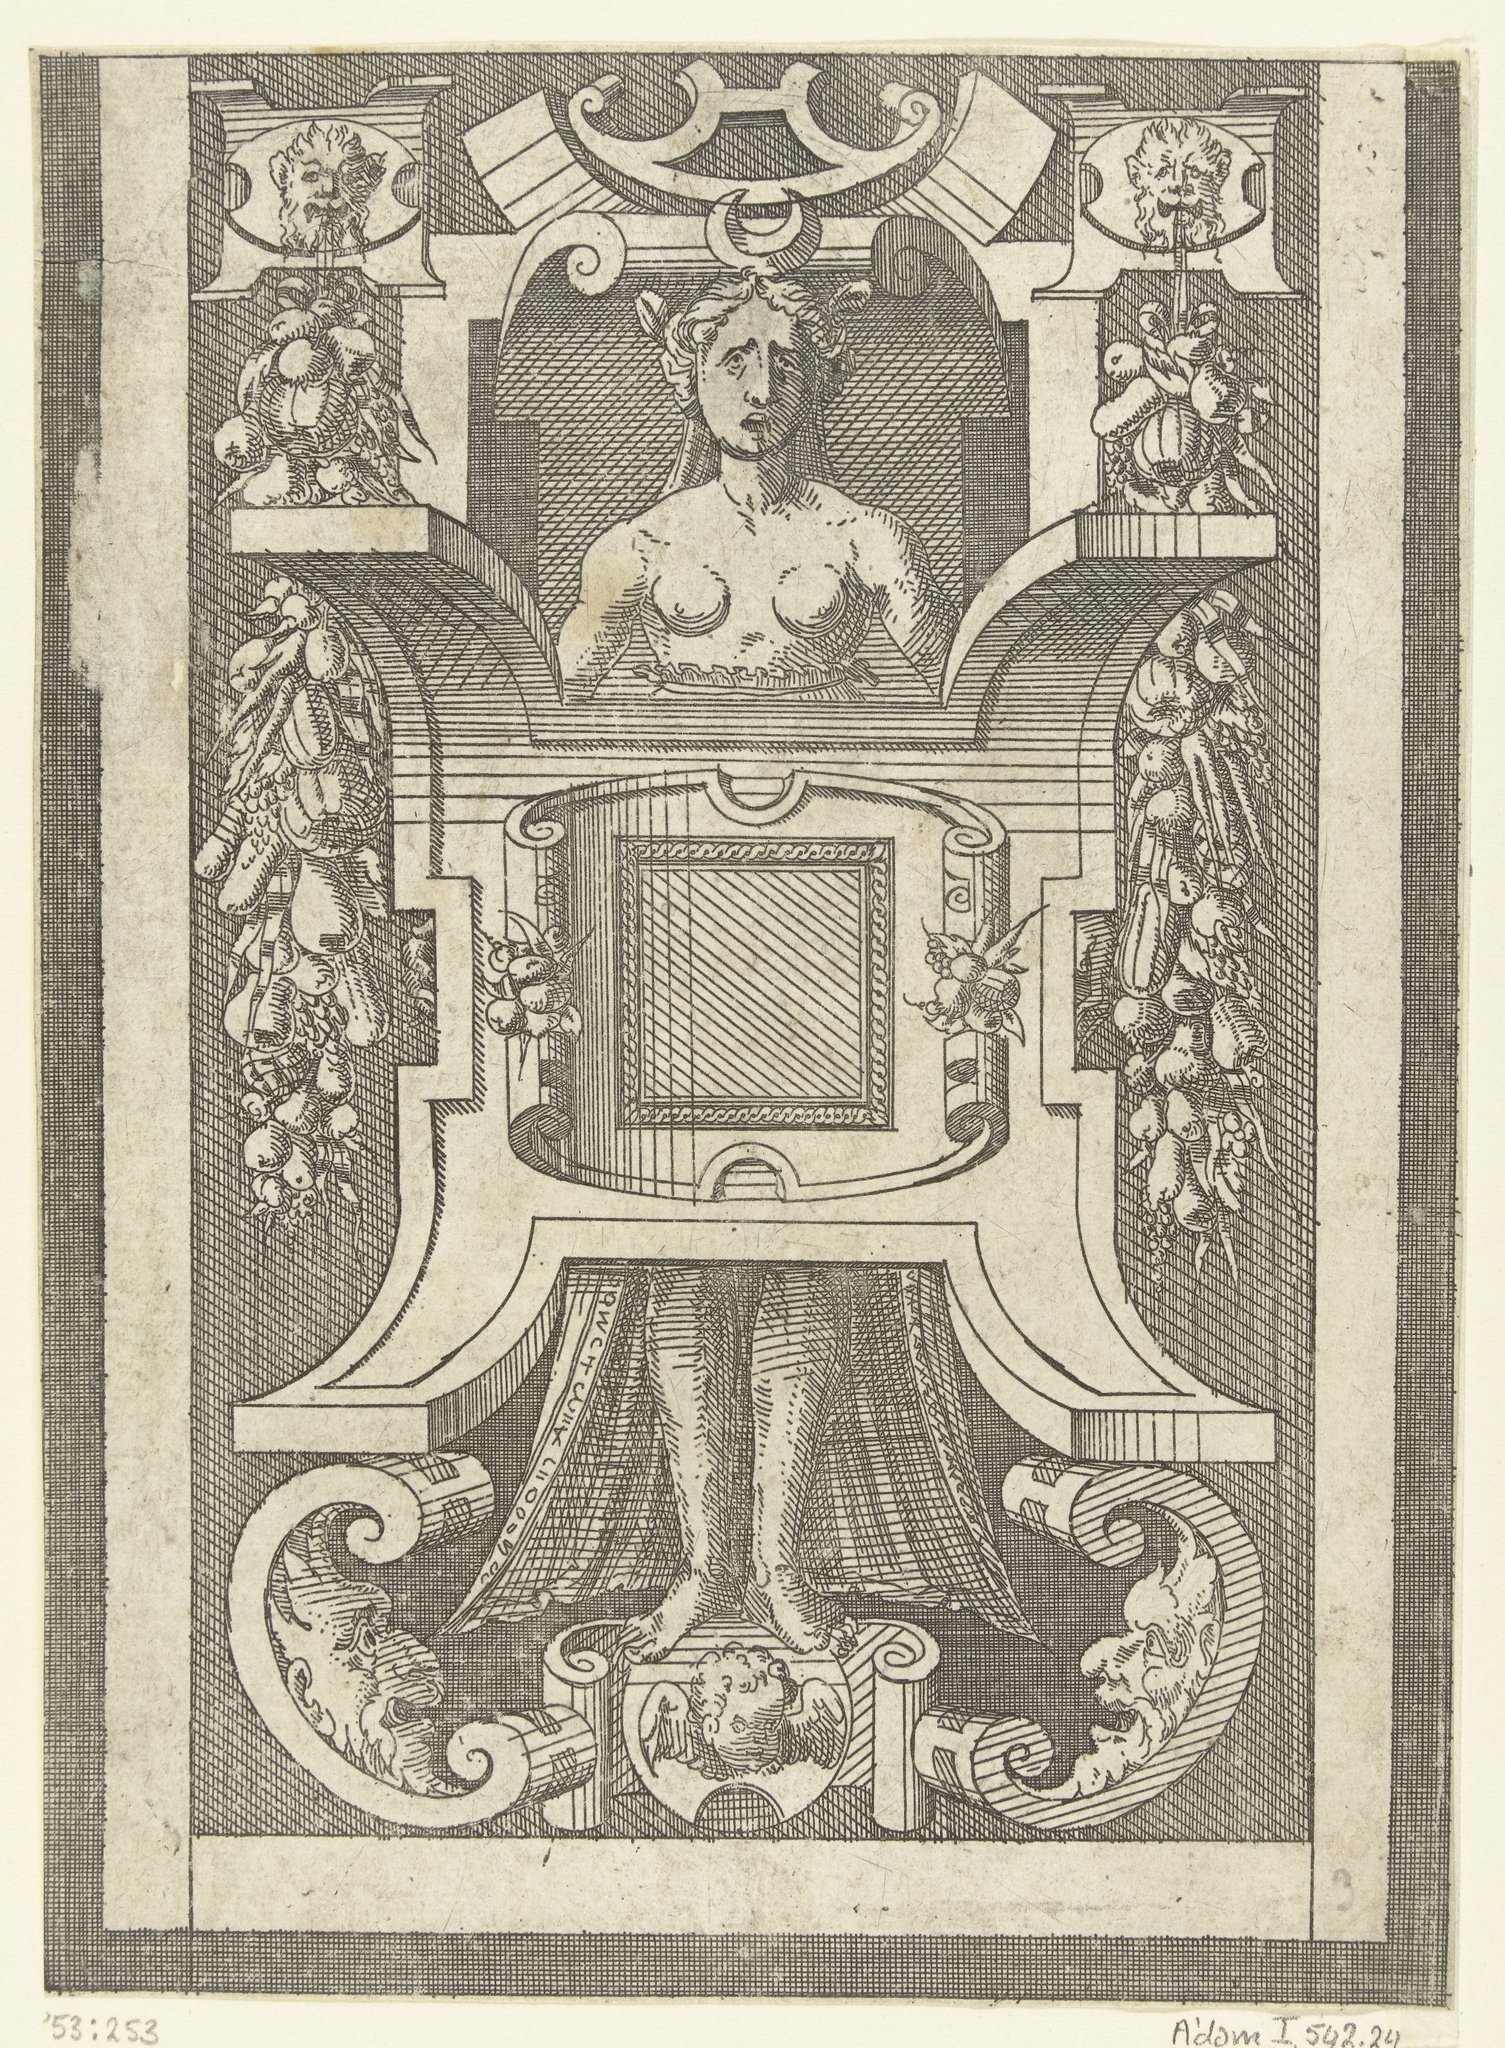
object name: print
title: Kleine cartouche naar voorbeeld te Fontainebleau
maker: Anonymous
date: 1520-1584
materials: paper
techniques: etching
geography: france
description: De cartouche wordt opgehouden door een vrouw met de maansikkel op haar hoofd. Uit serie van 32 bladen. De cartouches zijn deels ontleend aan de prenten van Antonio Fantuzzi naar de decoratie van de Galerie van François 1er door Giovanni Battista Rosso. De serie staat ook bekend onder de titel Petits cartouches de Fontainebleau.